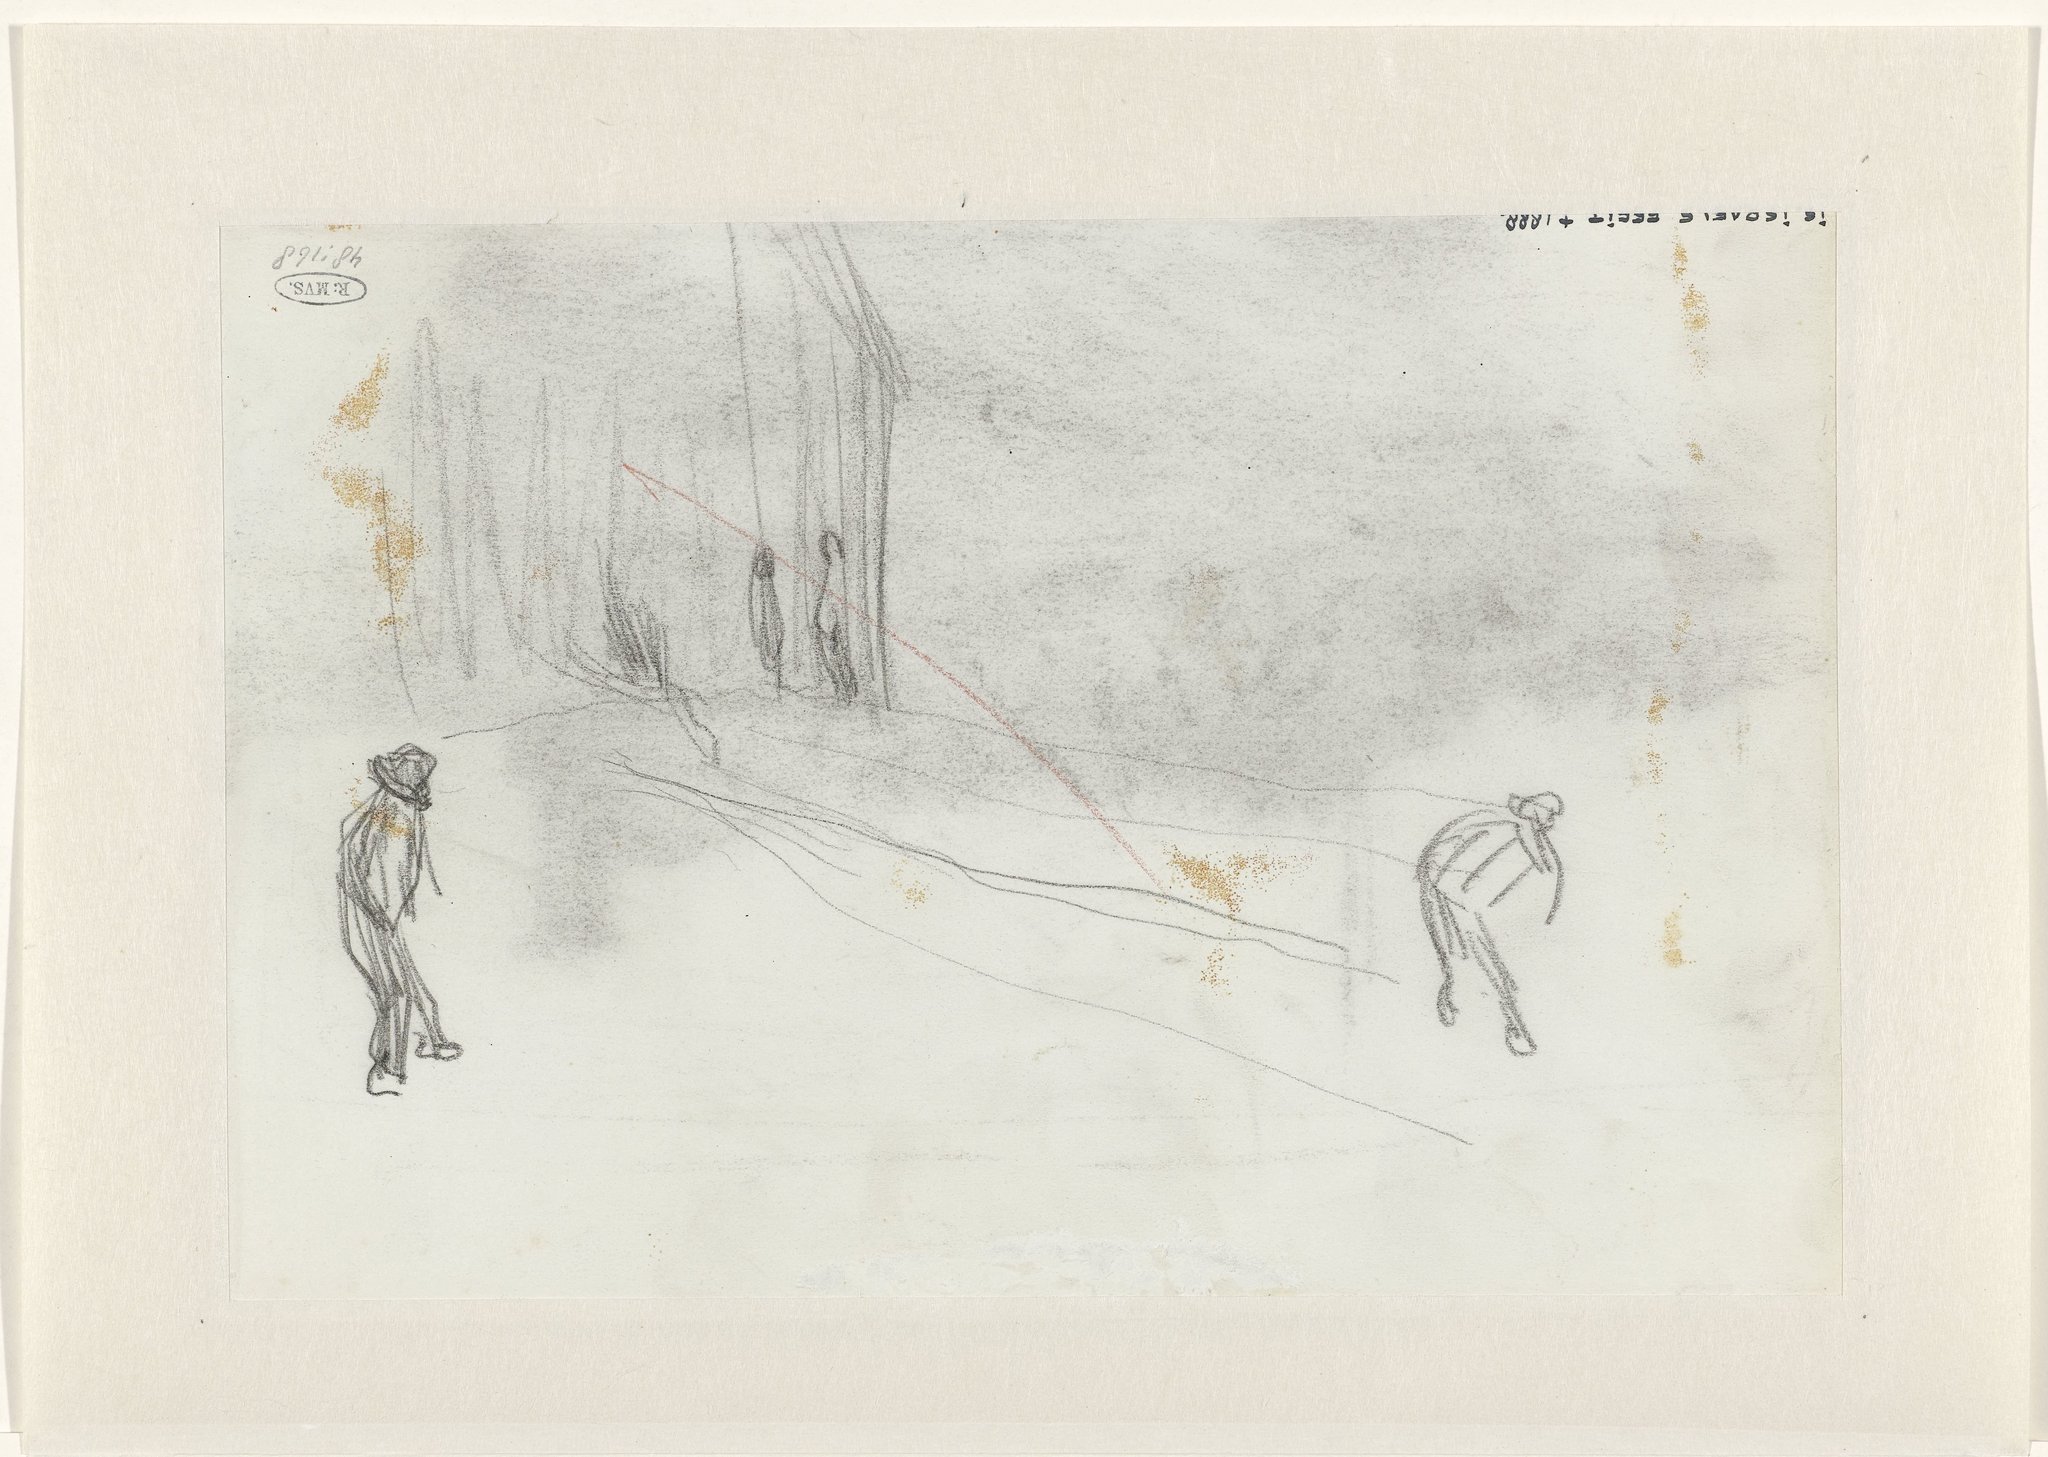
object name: drawing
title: Enkele personen bij een gebouw (doorgestreept)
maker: isaac israels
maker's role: draughtsman, painter, print maker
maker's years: 1865-1934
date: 1888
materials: chalk, paper